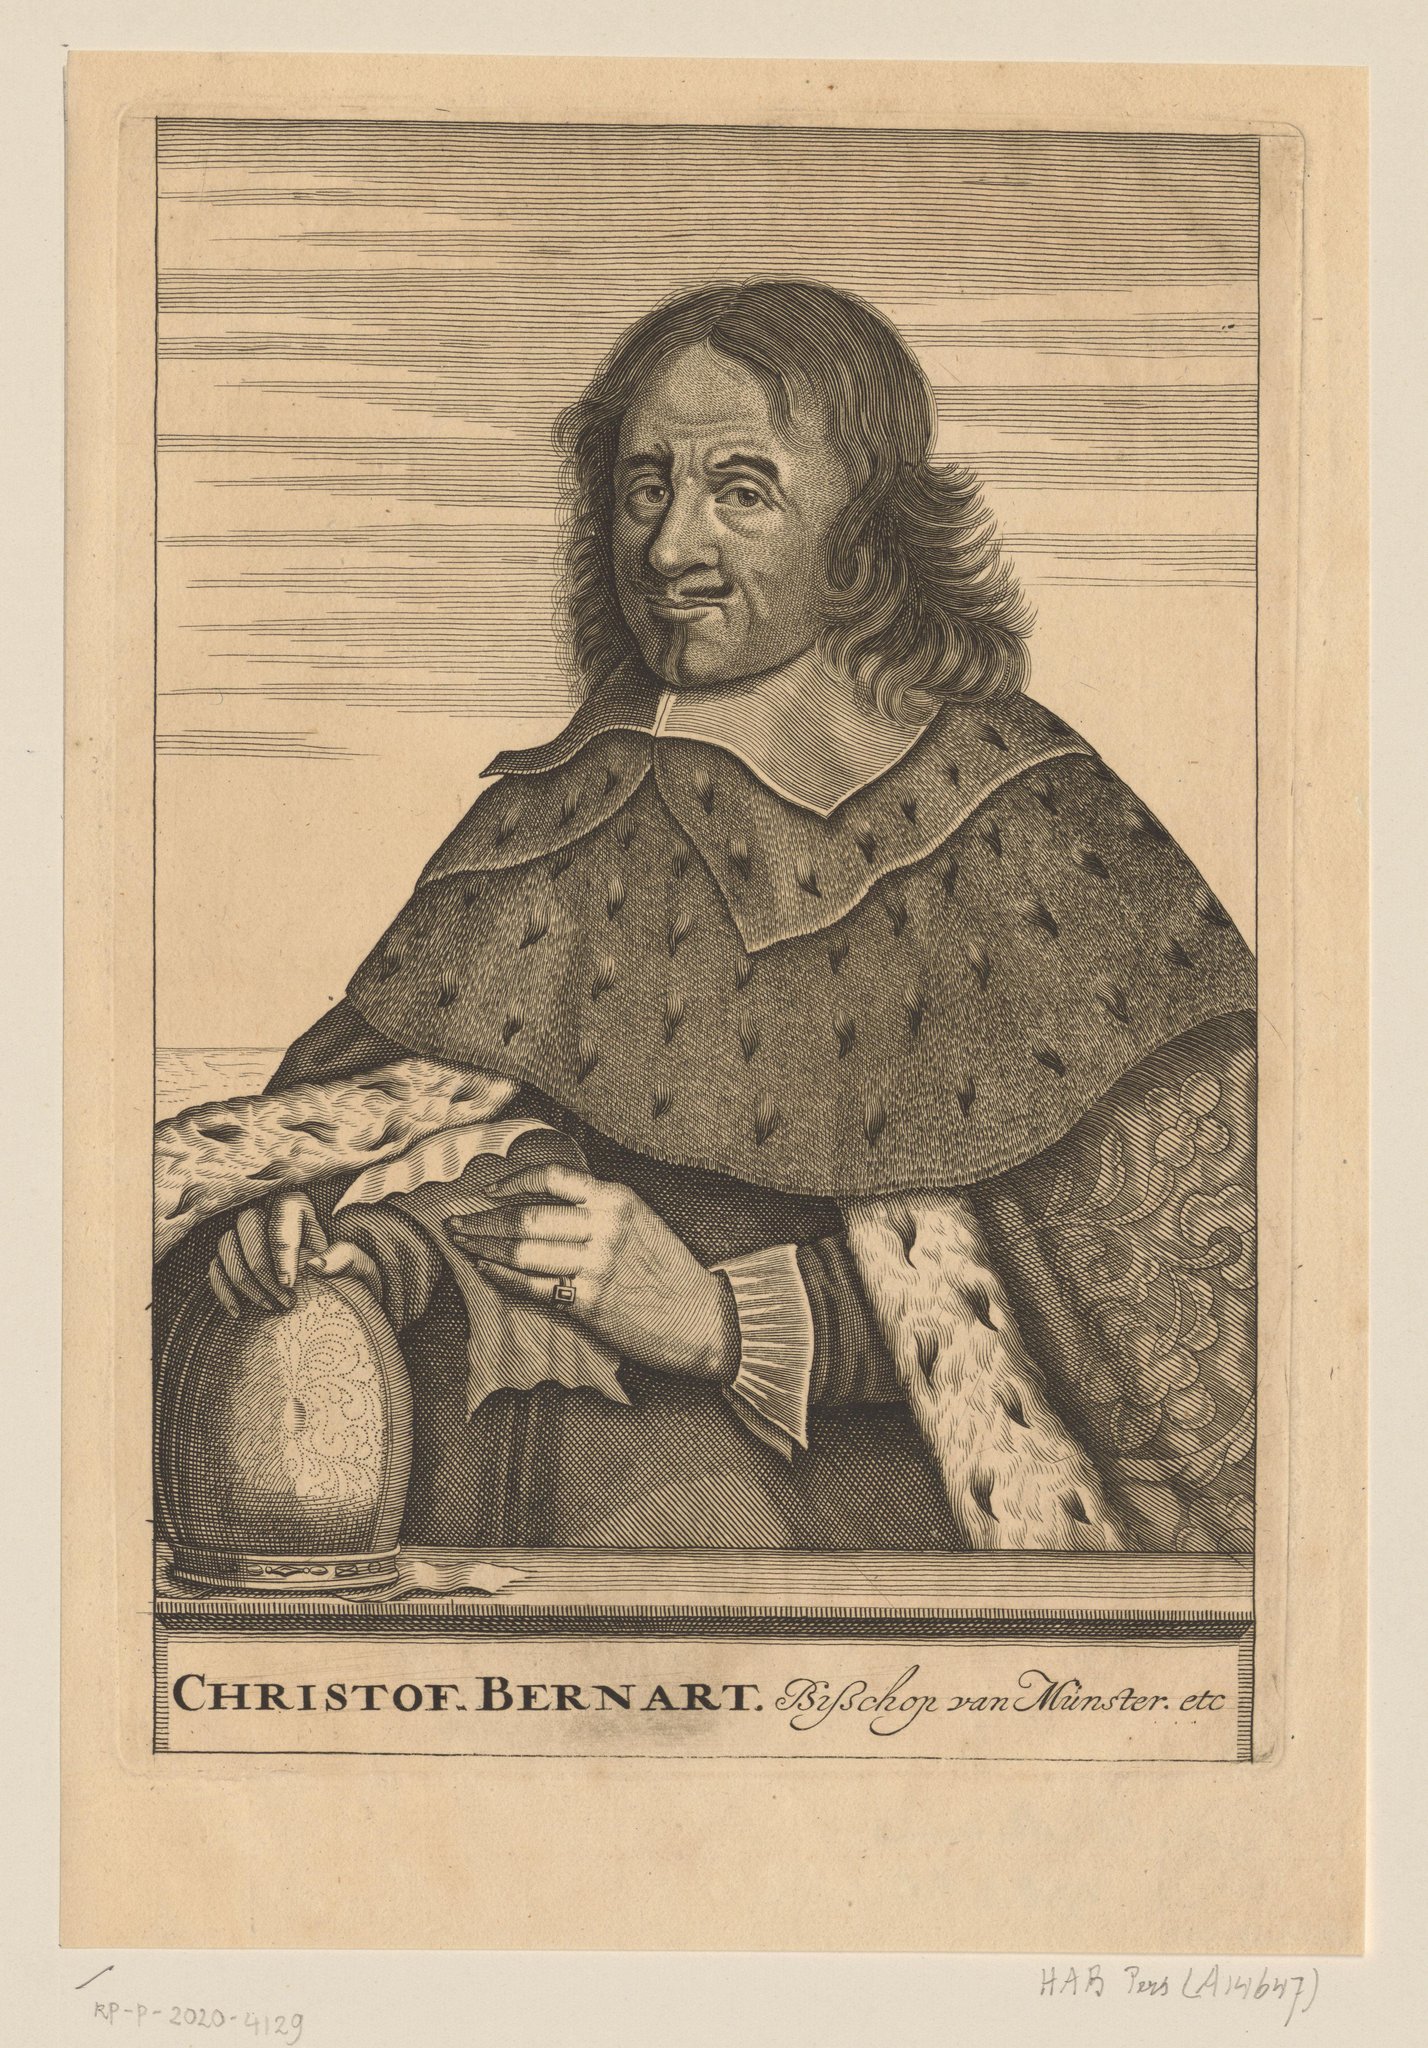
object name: print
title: Portret van Christoph Bernhard von Galen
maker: Anonymous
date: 1670-1678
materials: paper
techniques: engraving, etching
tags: theologian, historical persons